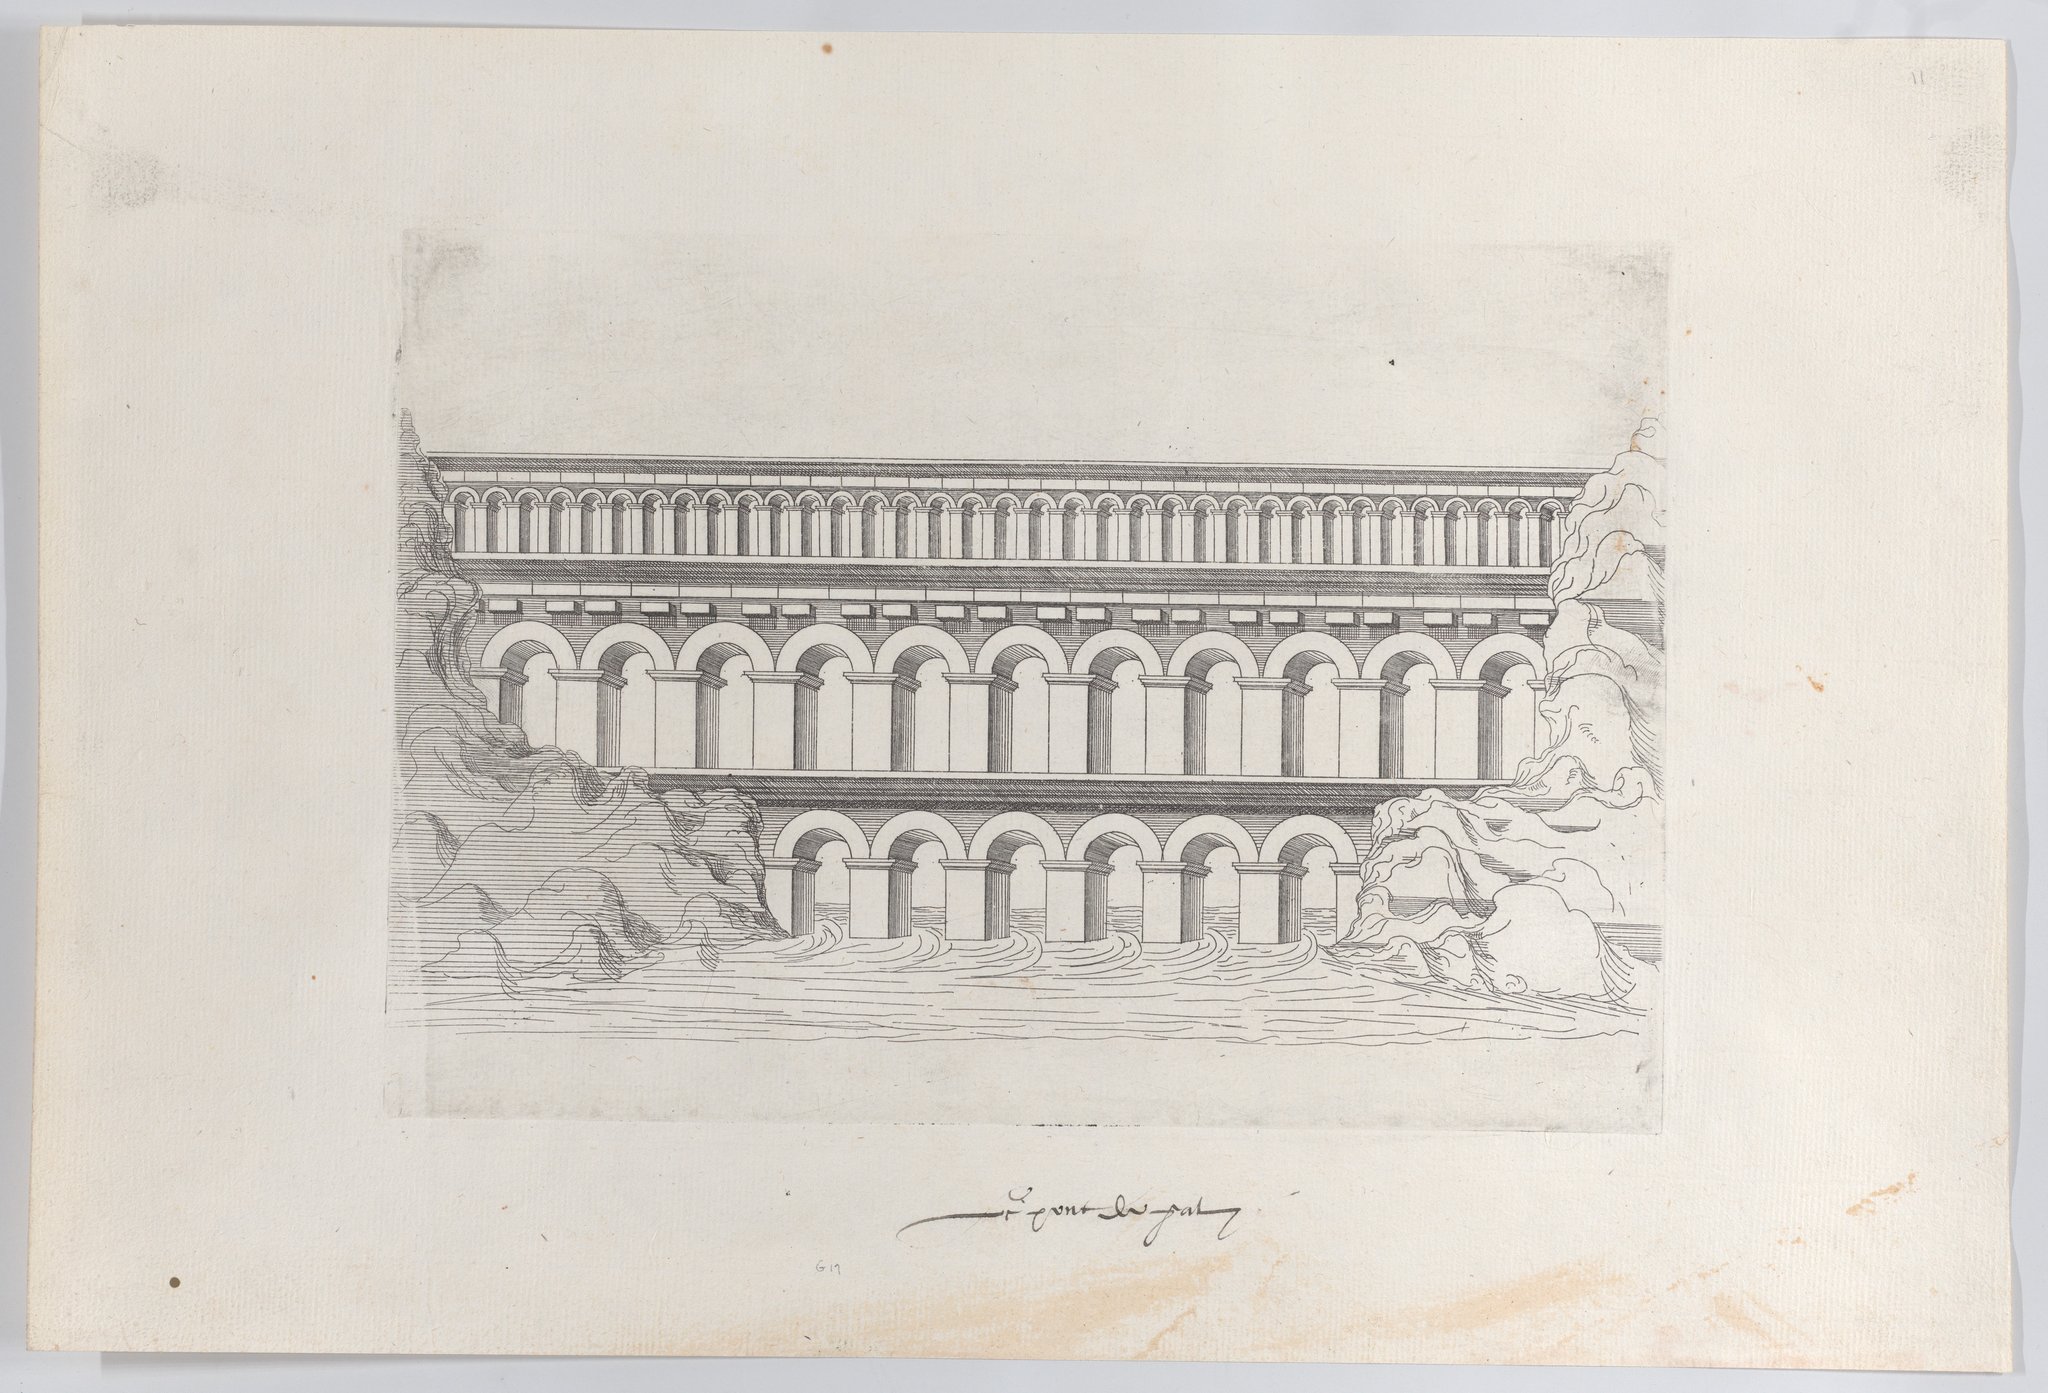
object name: print ornament architecture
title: The Bridge of the Gal (Gard)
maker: jacques androuet du cerceau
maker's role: artist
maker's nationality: french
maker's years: 1510-1585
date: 1545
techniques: etching